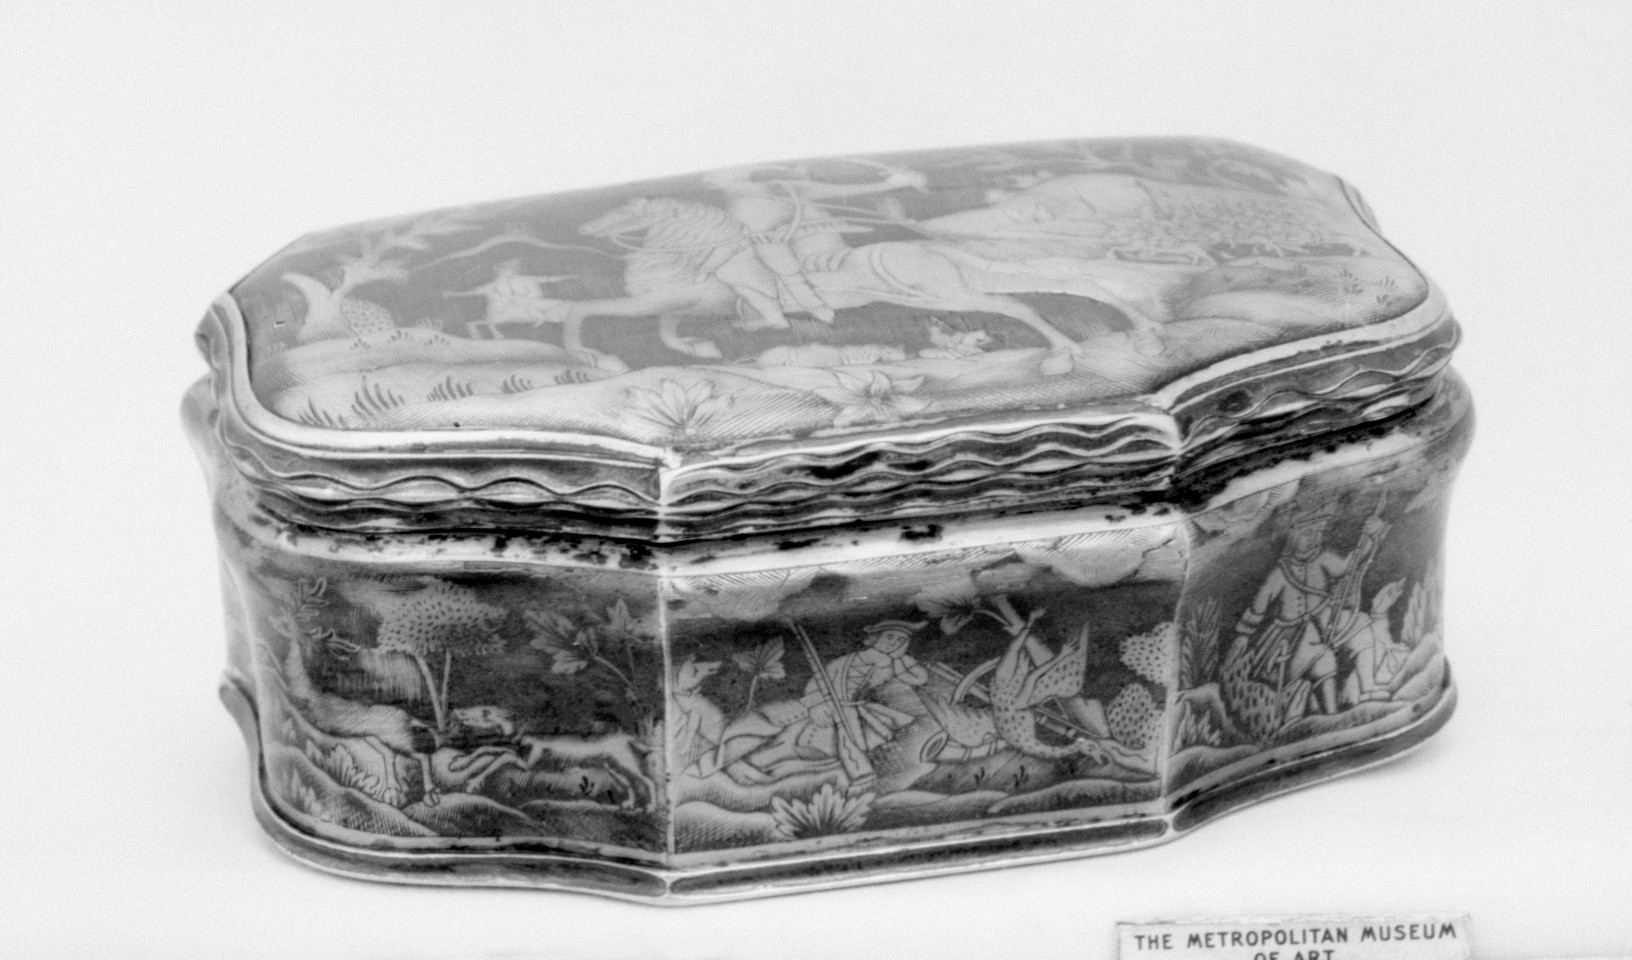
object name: box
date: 1734-1766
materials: gilt, niello, silver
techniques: lining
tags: birds,hunting,deer,dogs,horses